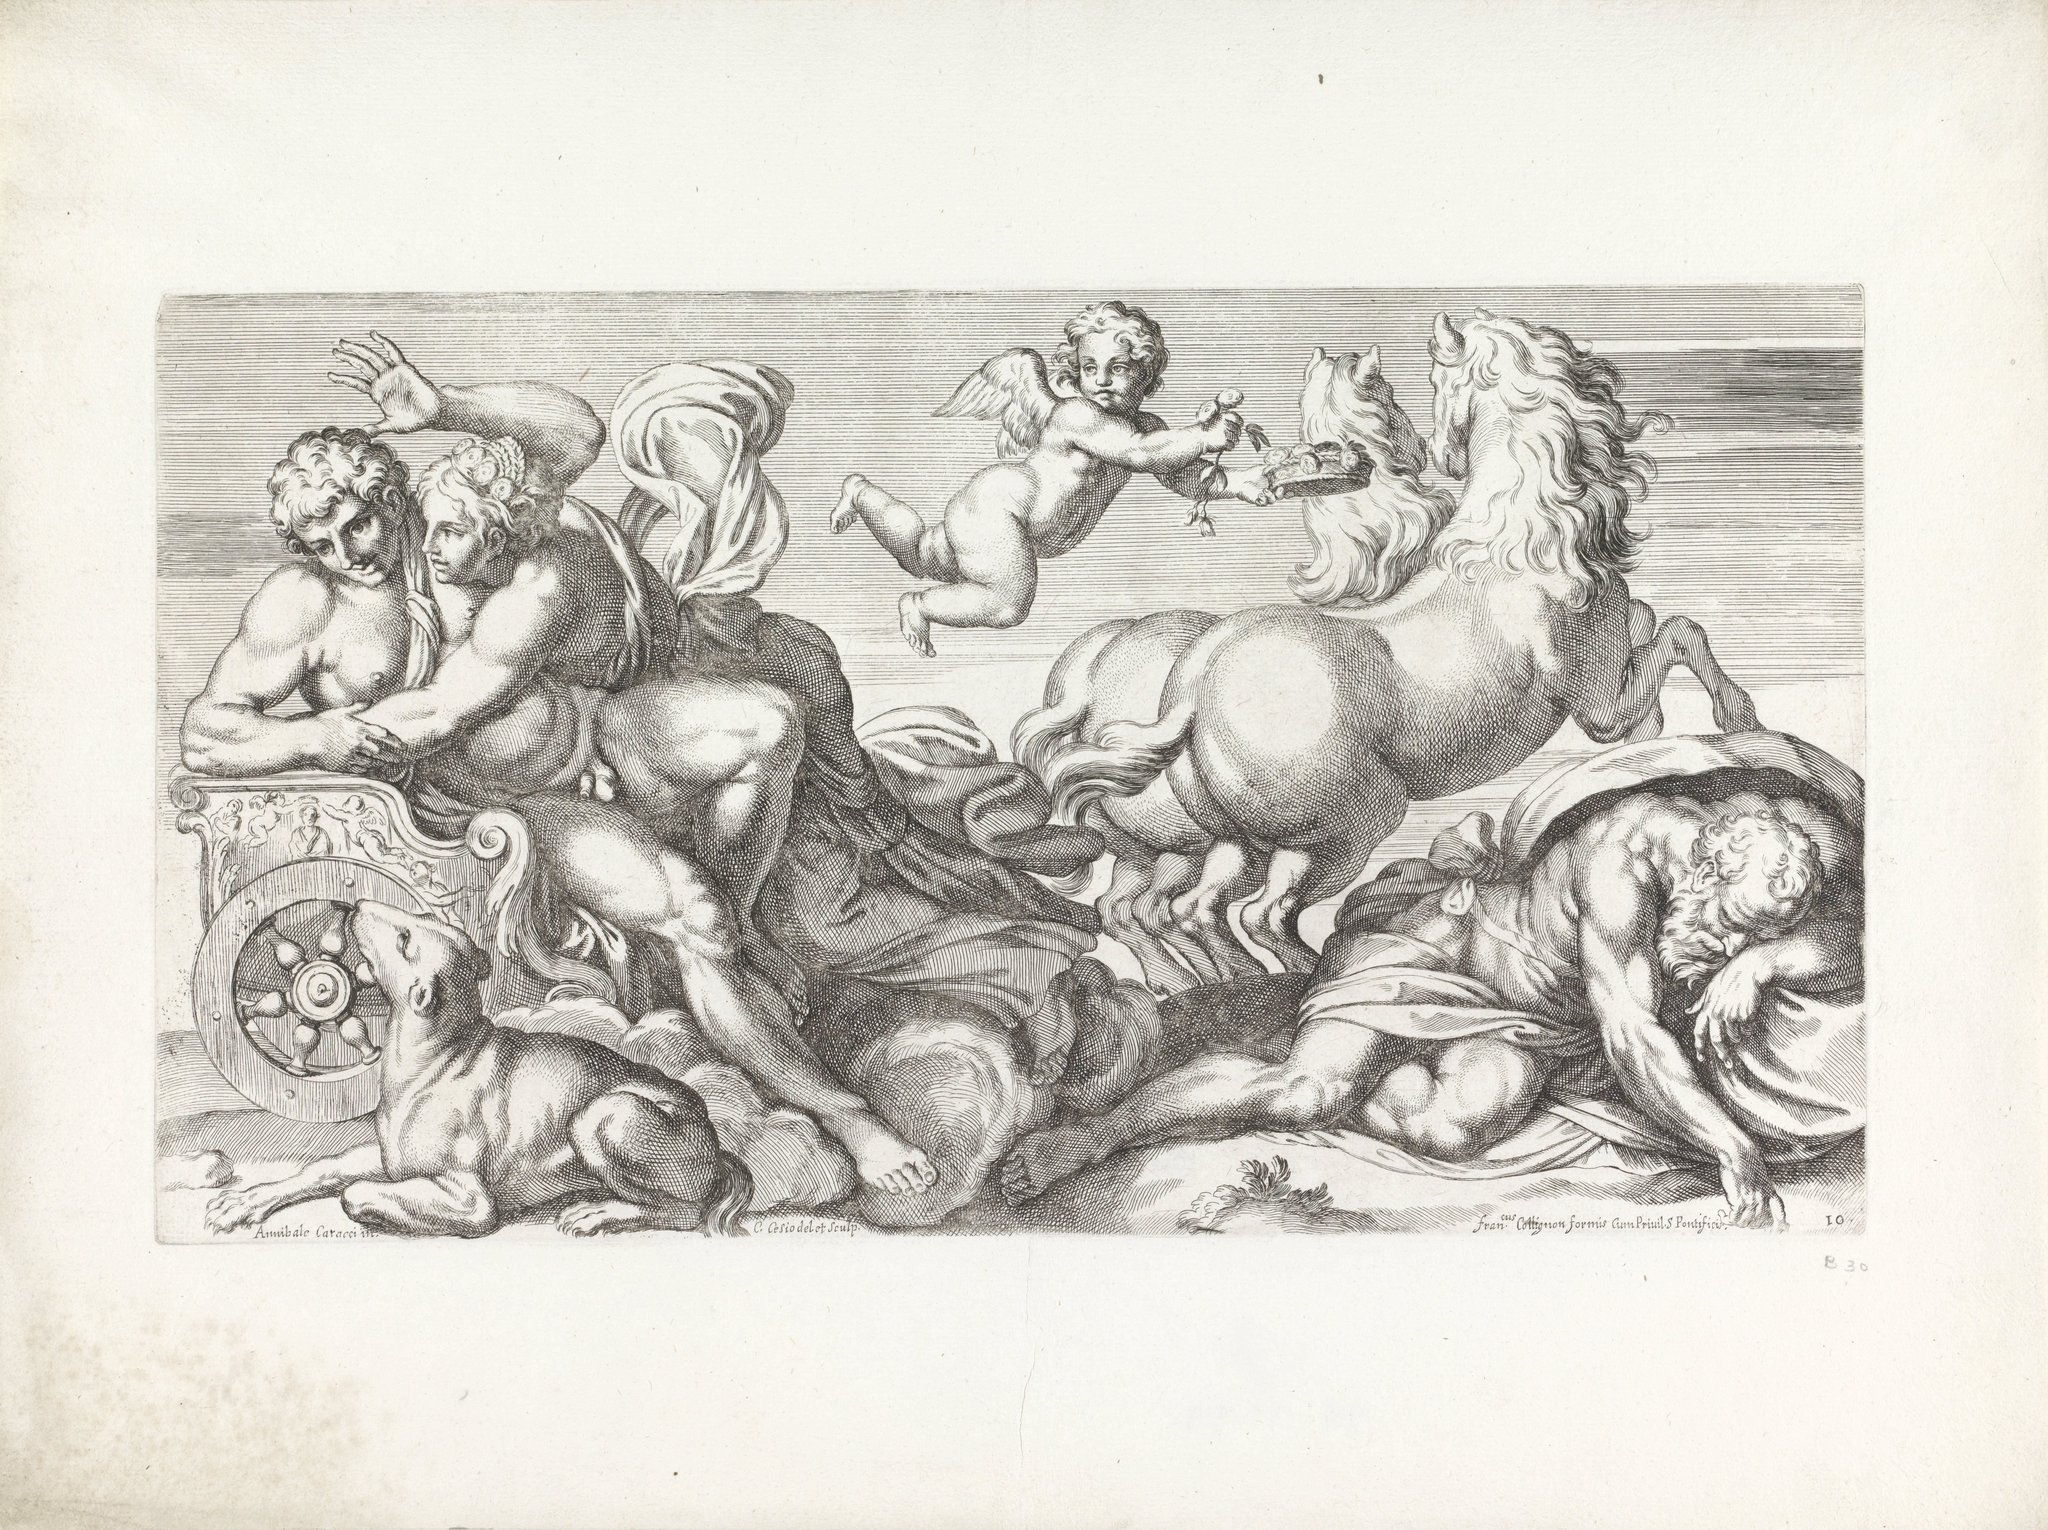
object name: print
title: Roof van Cephalus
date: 1656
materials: paper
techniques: etching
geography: italy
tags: aurora carrying off cephalus, cephalus and aurora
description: Prent uit een reeks prenten met nummers van 1 tot en met 29 (sommige prenten hebben hetzelfde nummer), plus titelprent en opdracht, naar schilderingen in Palazzo Farnese te Rome.